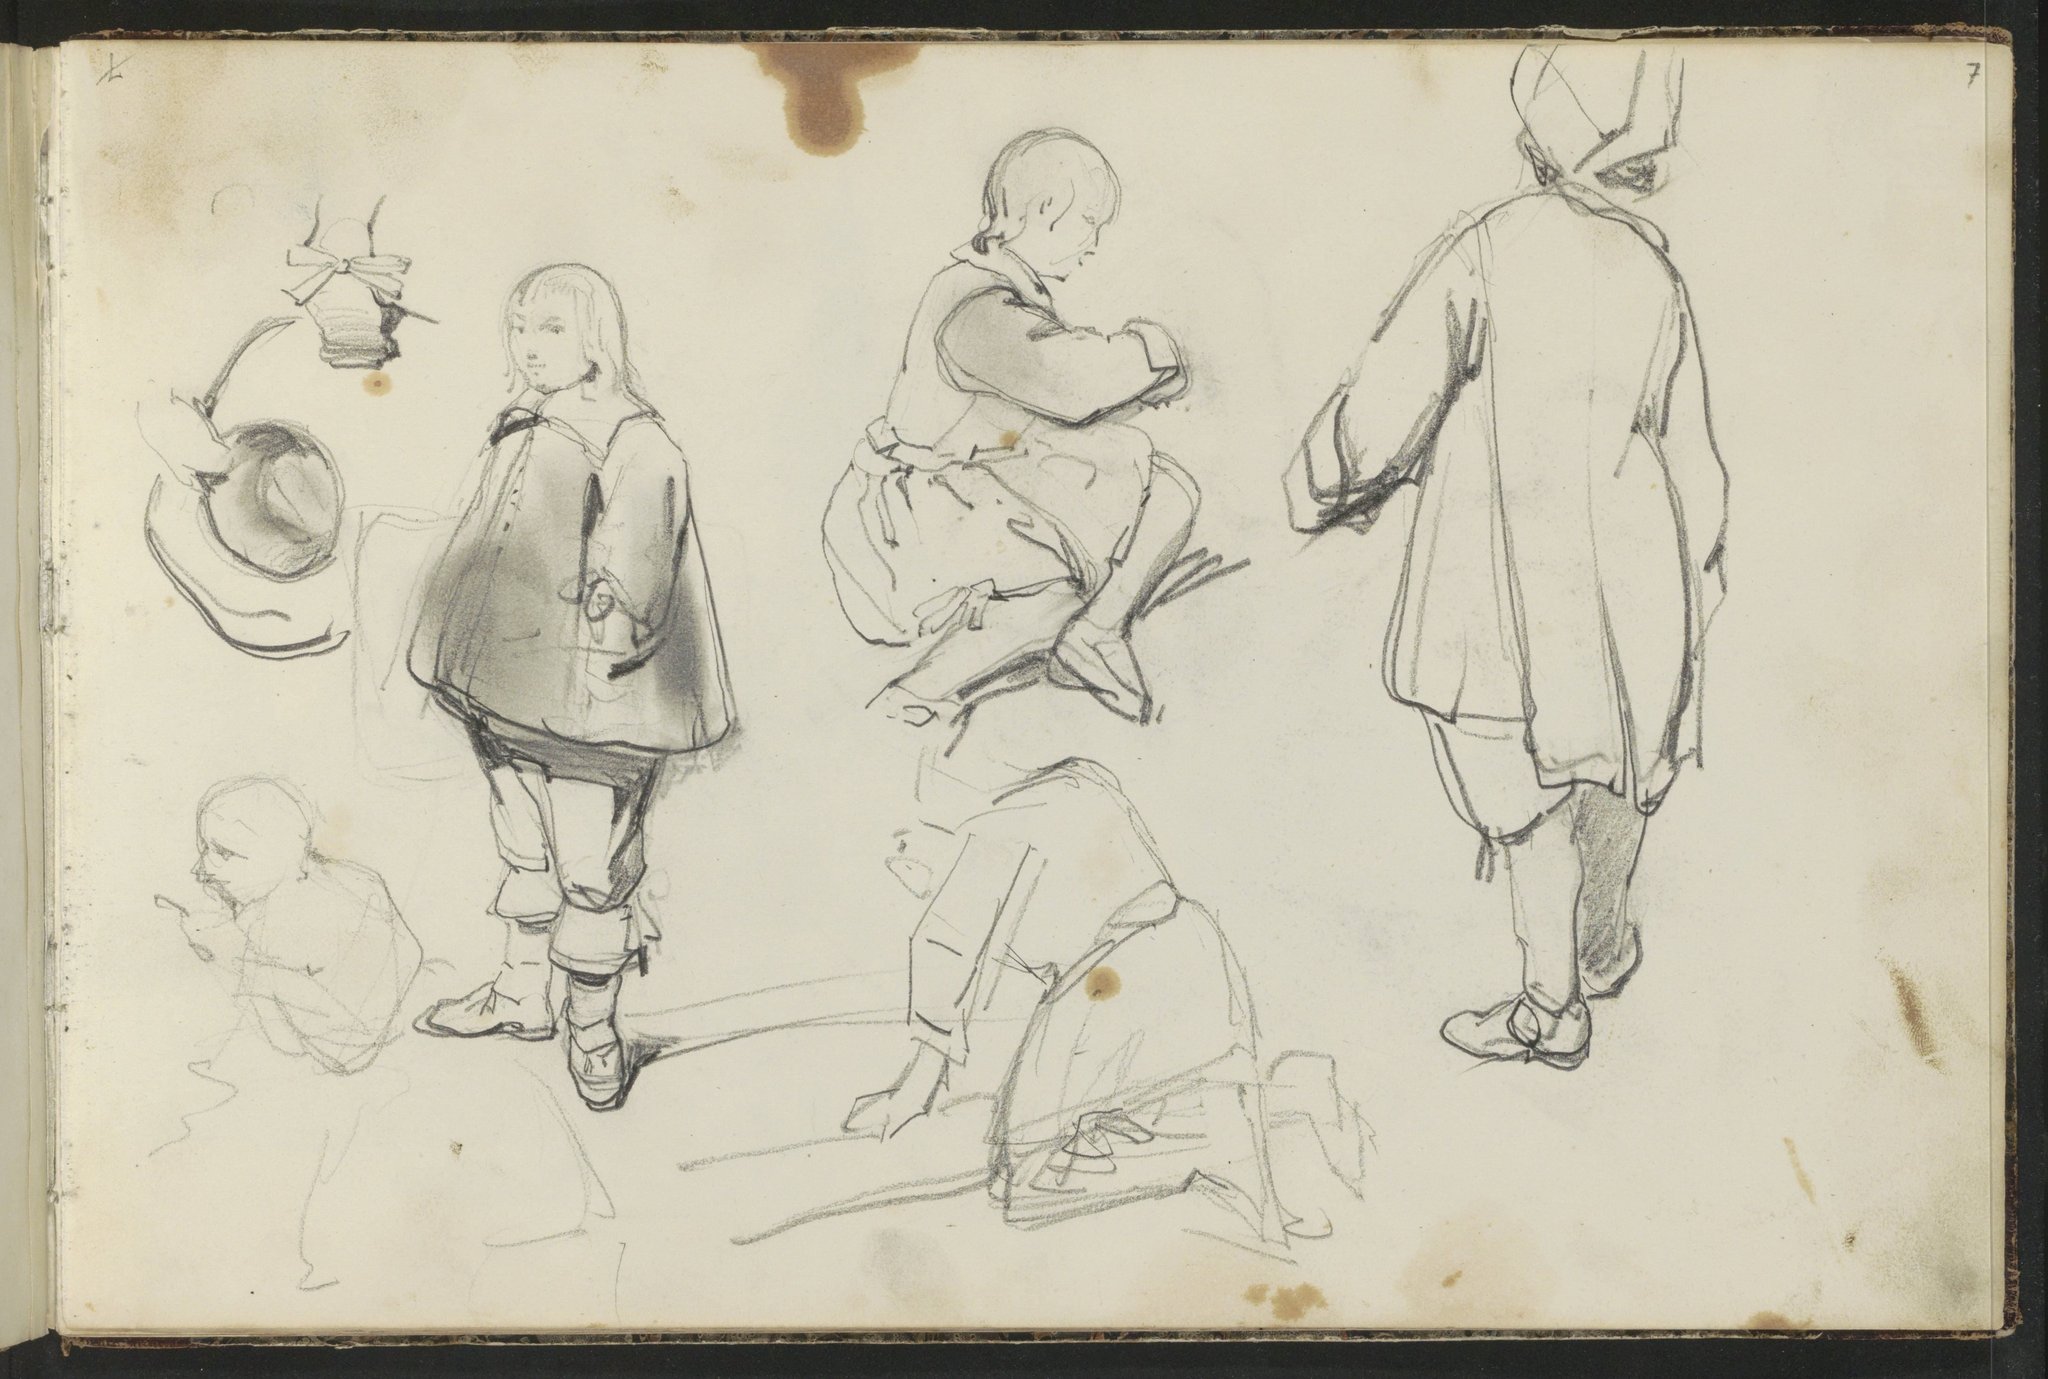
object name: sketchbook leaf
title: Kinderen, onder wie een jongen in historisch kostuum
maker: johannes bosboom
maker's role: draughtsman, painter, print maker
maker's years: 1817-1891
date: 1827-1891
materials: paper, pencil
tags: child, historical costume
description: Tevens een studie van een voet en hoed. Blad 7 recto uit een schetsboek met 11 bladen.